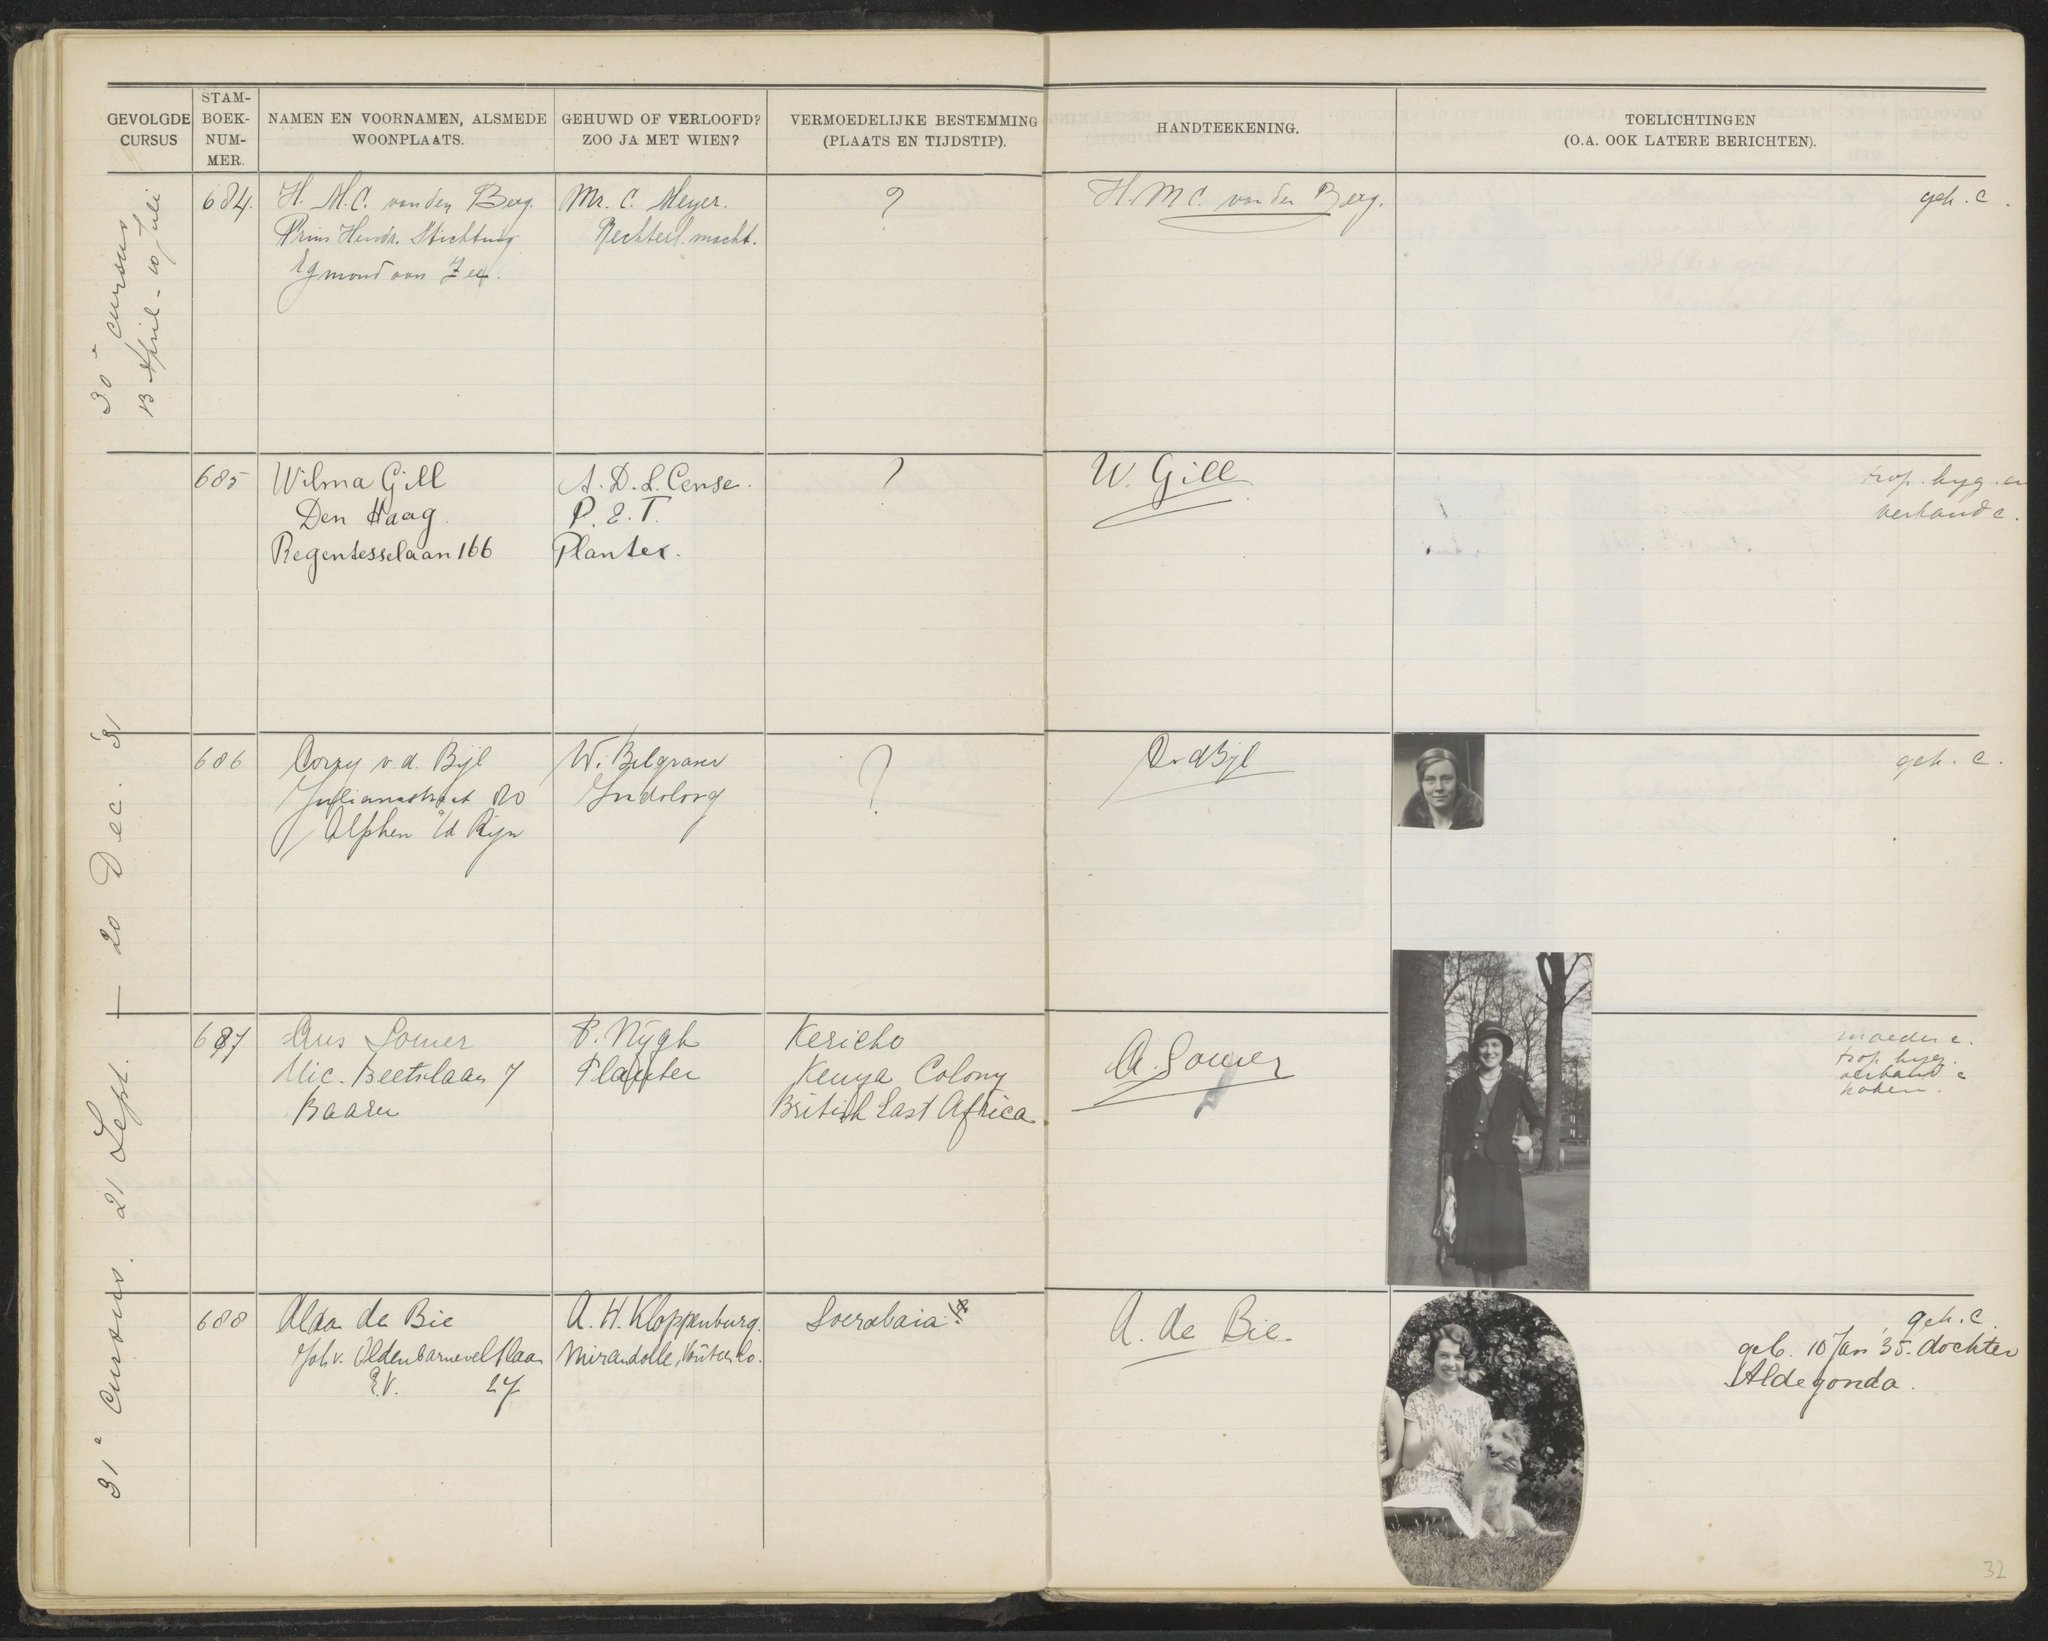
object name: album leaf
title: Blad 32 uit Stamboek van de leerlingen der Koloniale School voor Meisjes en Vrouwen te 's-Gravenhage deel II (1930-1949)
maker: Anonymous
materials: paper, photographic support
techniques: photography, printing, writing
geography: the hague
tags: further education (+ pupil), further education, the hague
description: Twee pagina's met gegevens van de deelnemers aan de 30e en 31e driemaandelijkse cursus resp. van 13 april tot en met 10 juli 1931 en 21 september tot en met 20 december 1931, stamboeknummers 684 tot en met 688. Onderdeel van Stamboek van de leerlingen der Koloniale School voor Meisjes en Vrouwen te 's-Gravenhage deel II (1930-1949).